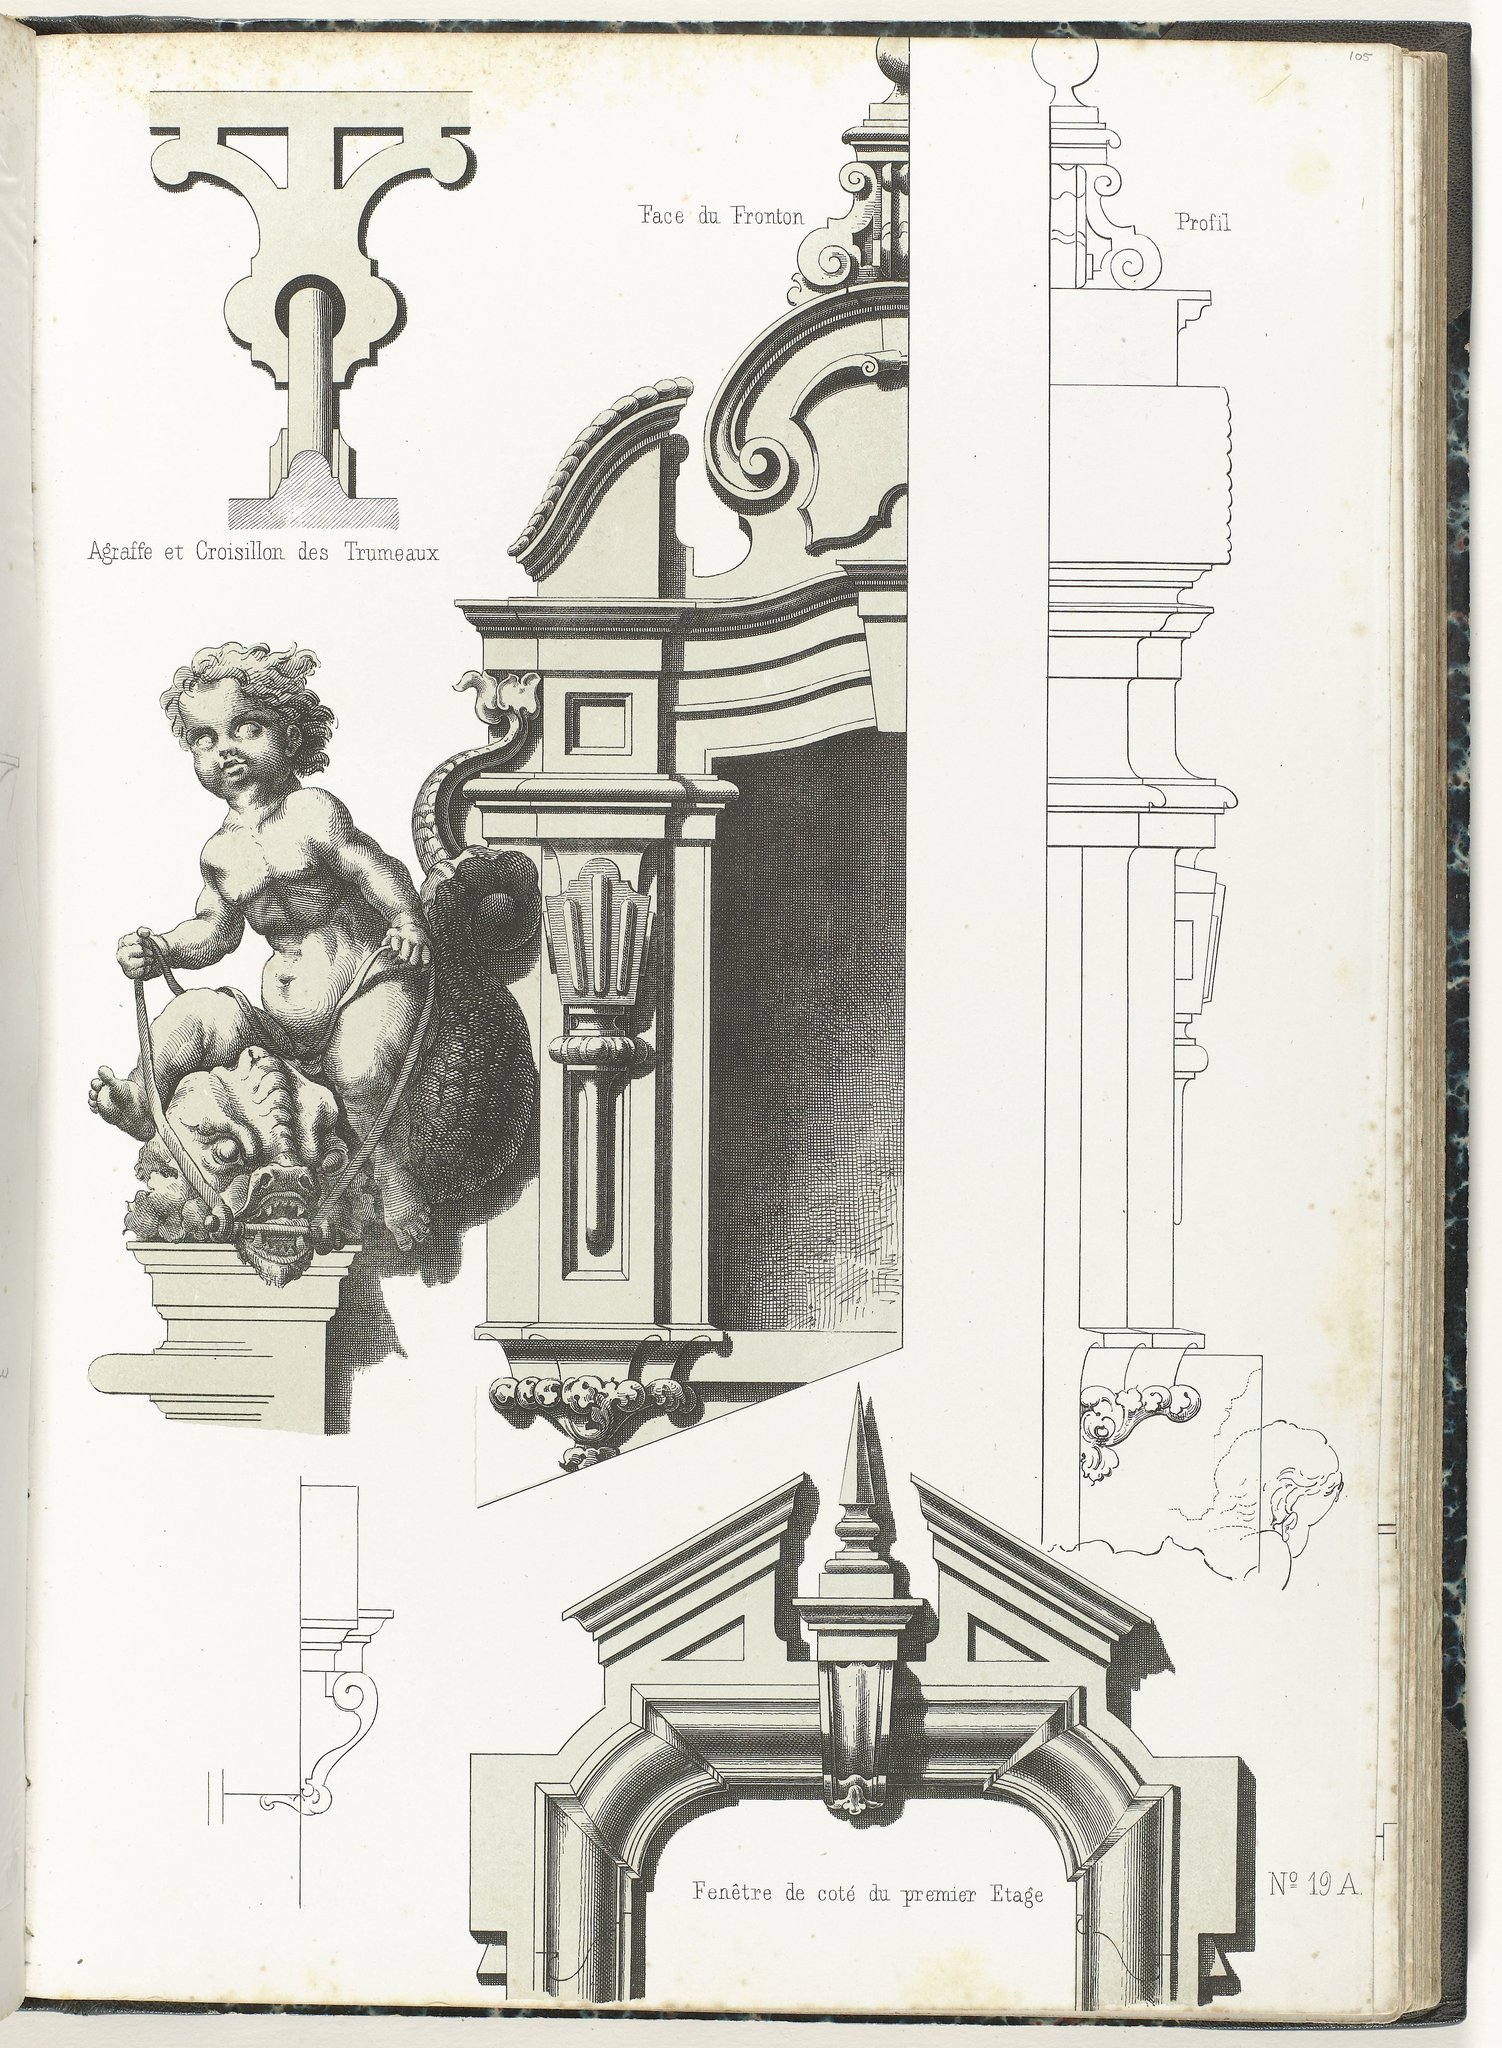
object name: print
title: Architecturale elementen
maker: Anonymous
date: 1866-1900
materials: paper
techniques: tone lithography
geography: liège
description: In het midden de voorkant van een fronton met weergave in profiel ernaast, links een putto zittend op een dolfijn, onderaan een venster met weergave in profiel. Bij de meeste onderdelen staat in het Frans aangeduid wat er afgebeeld is. Rechtsonder staat vermeld: N° 19 A.